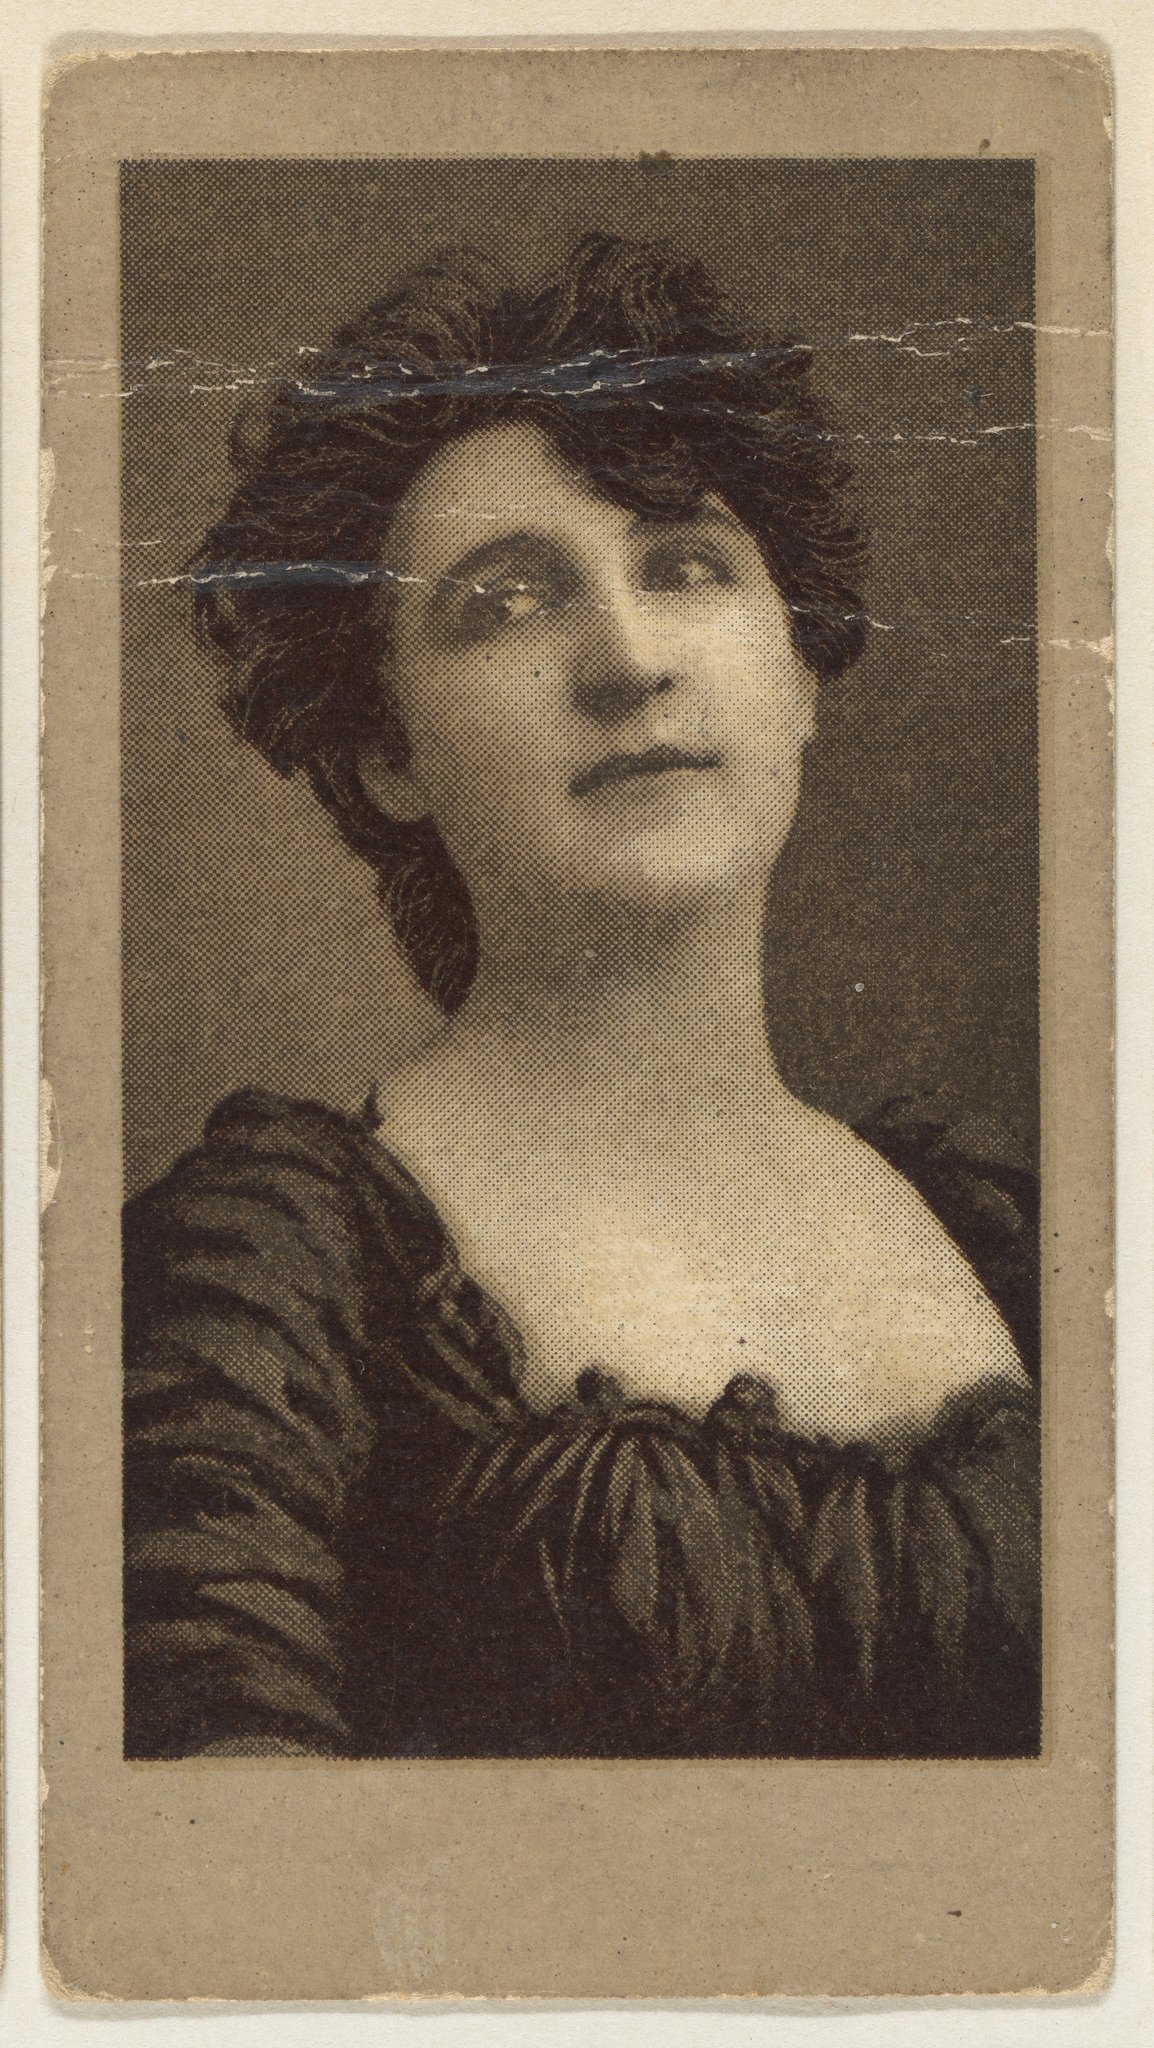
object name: print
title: Portrait of a woman looking to the left, from the "Girls" series (T66), issued with Hunter Dog Cigarros by S. Monday & Sons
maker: s. monday & sons, brooklyn, new york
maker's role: publisher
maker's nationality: american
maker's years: 1850-1950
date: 1900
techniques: photolithograph